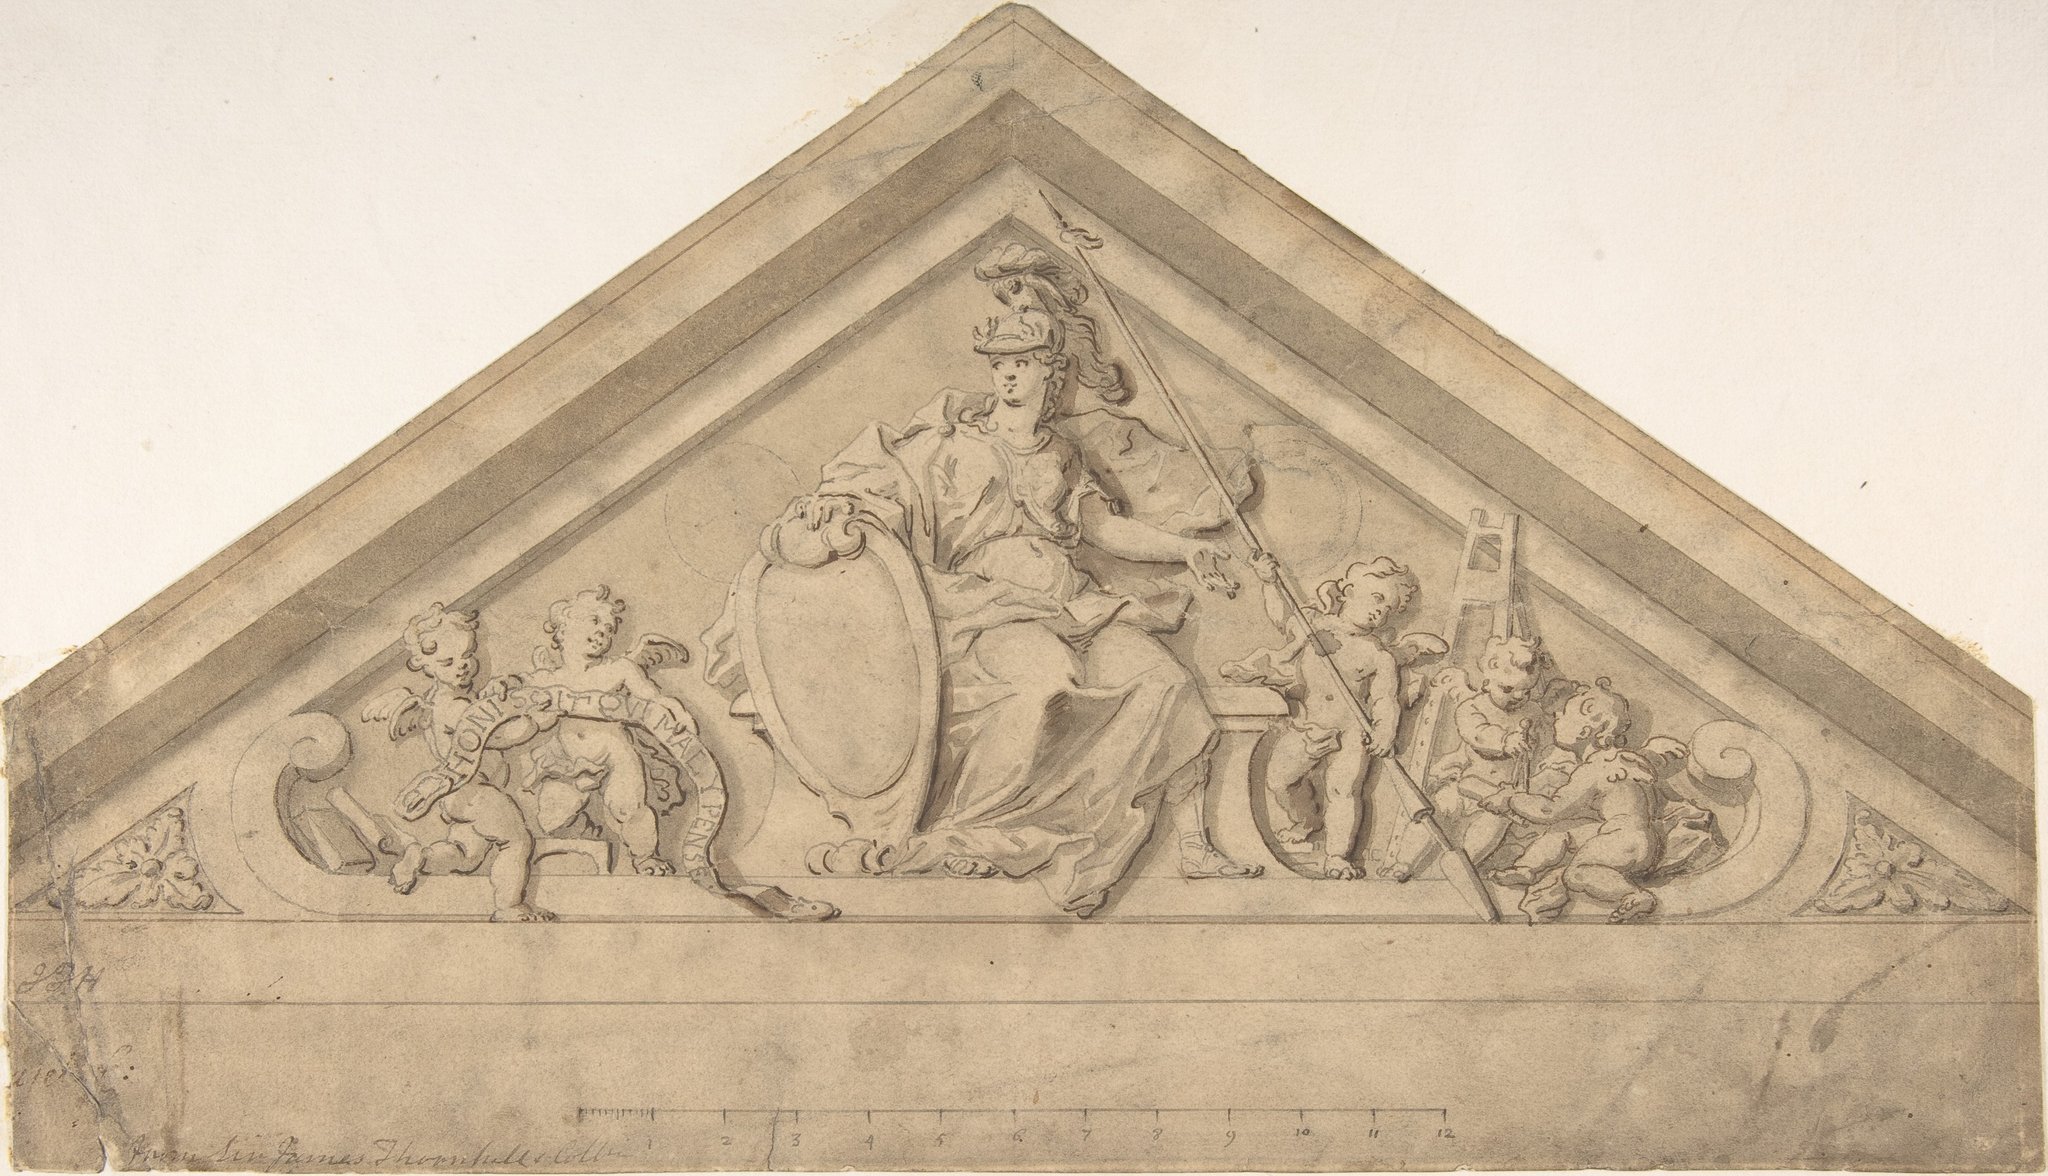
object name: drawing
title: Design for a Pediment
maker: bouget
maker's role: artist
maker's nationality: french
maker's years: 1700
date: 1700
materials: ink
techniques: brush, pen, wash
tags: women,putti